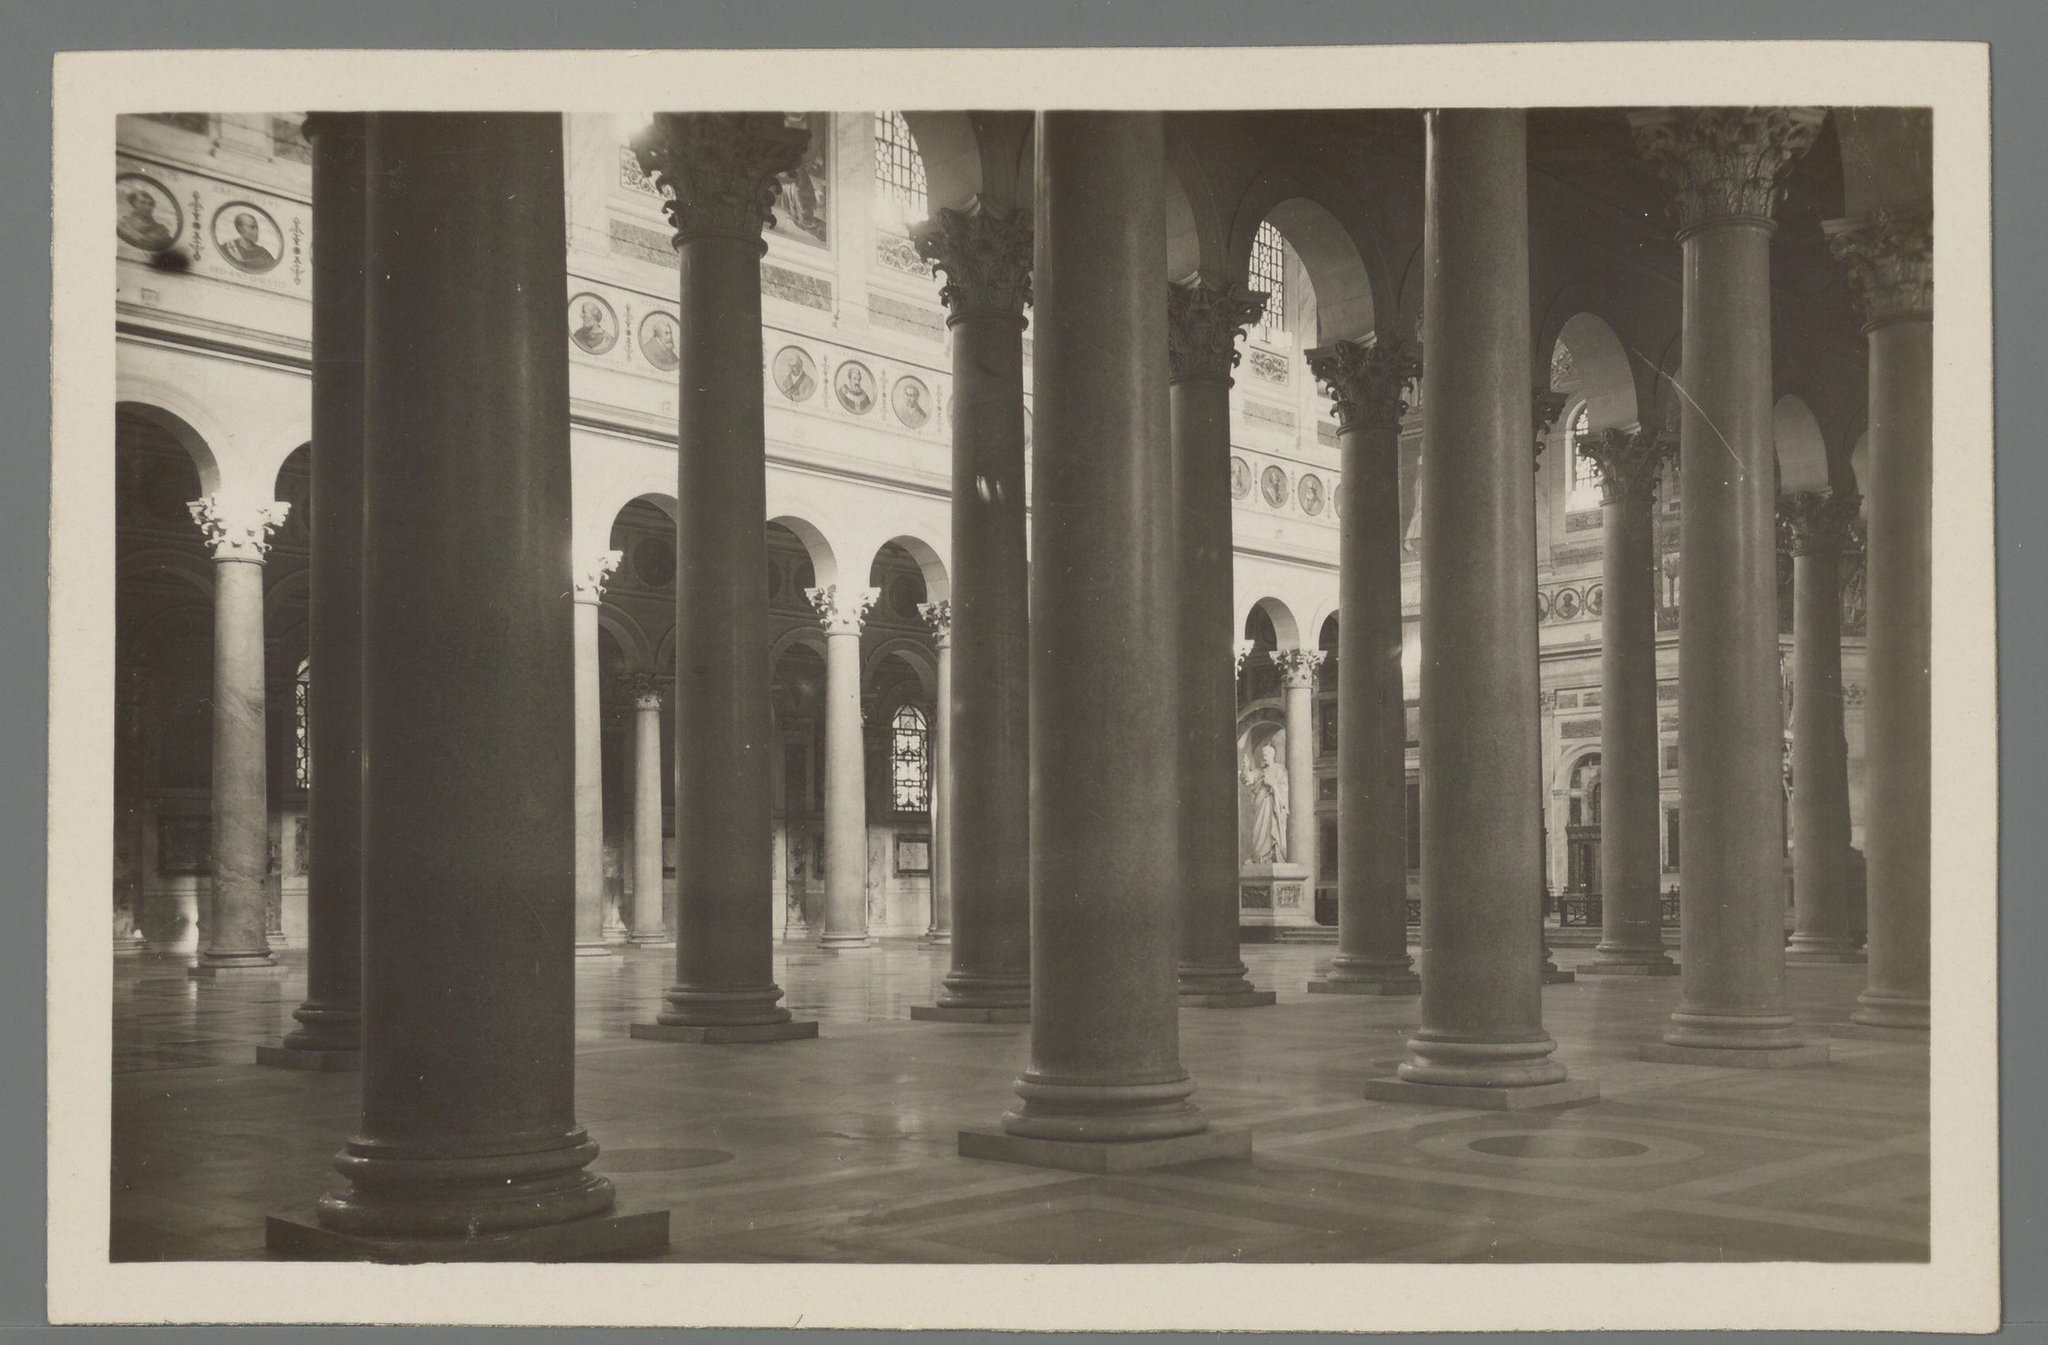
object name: photograph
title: Roma. Interno della Basilica di S. Paolo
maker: Anonymous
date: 1932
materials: photographic support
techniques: photography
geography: rome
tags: interior of church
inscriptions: date